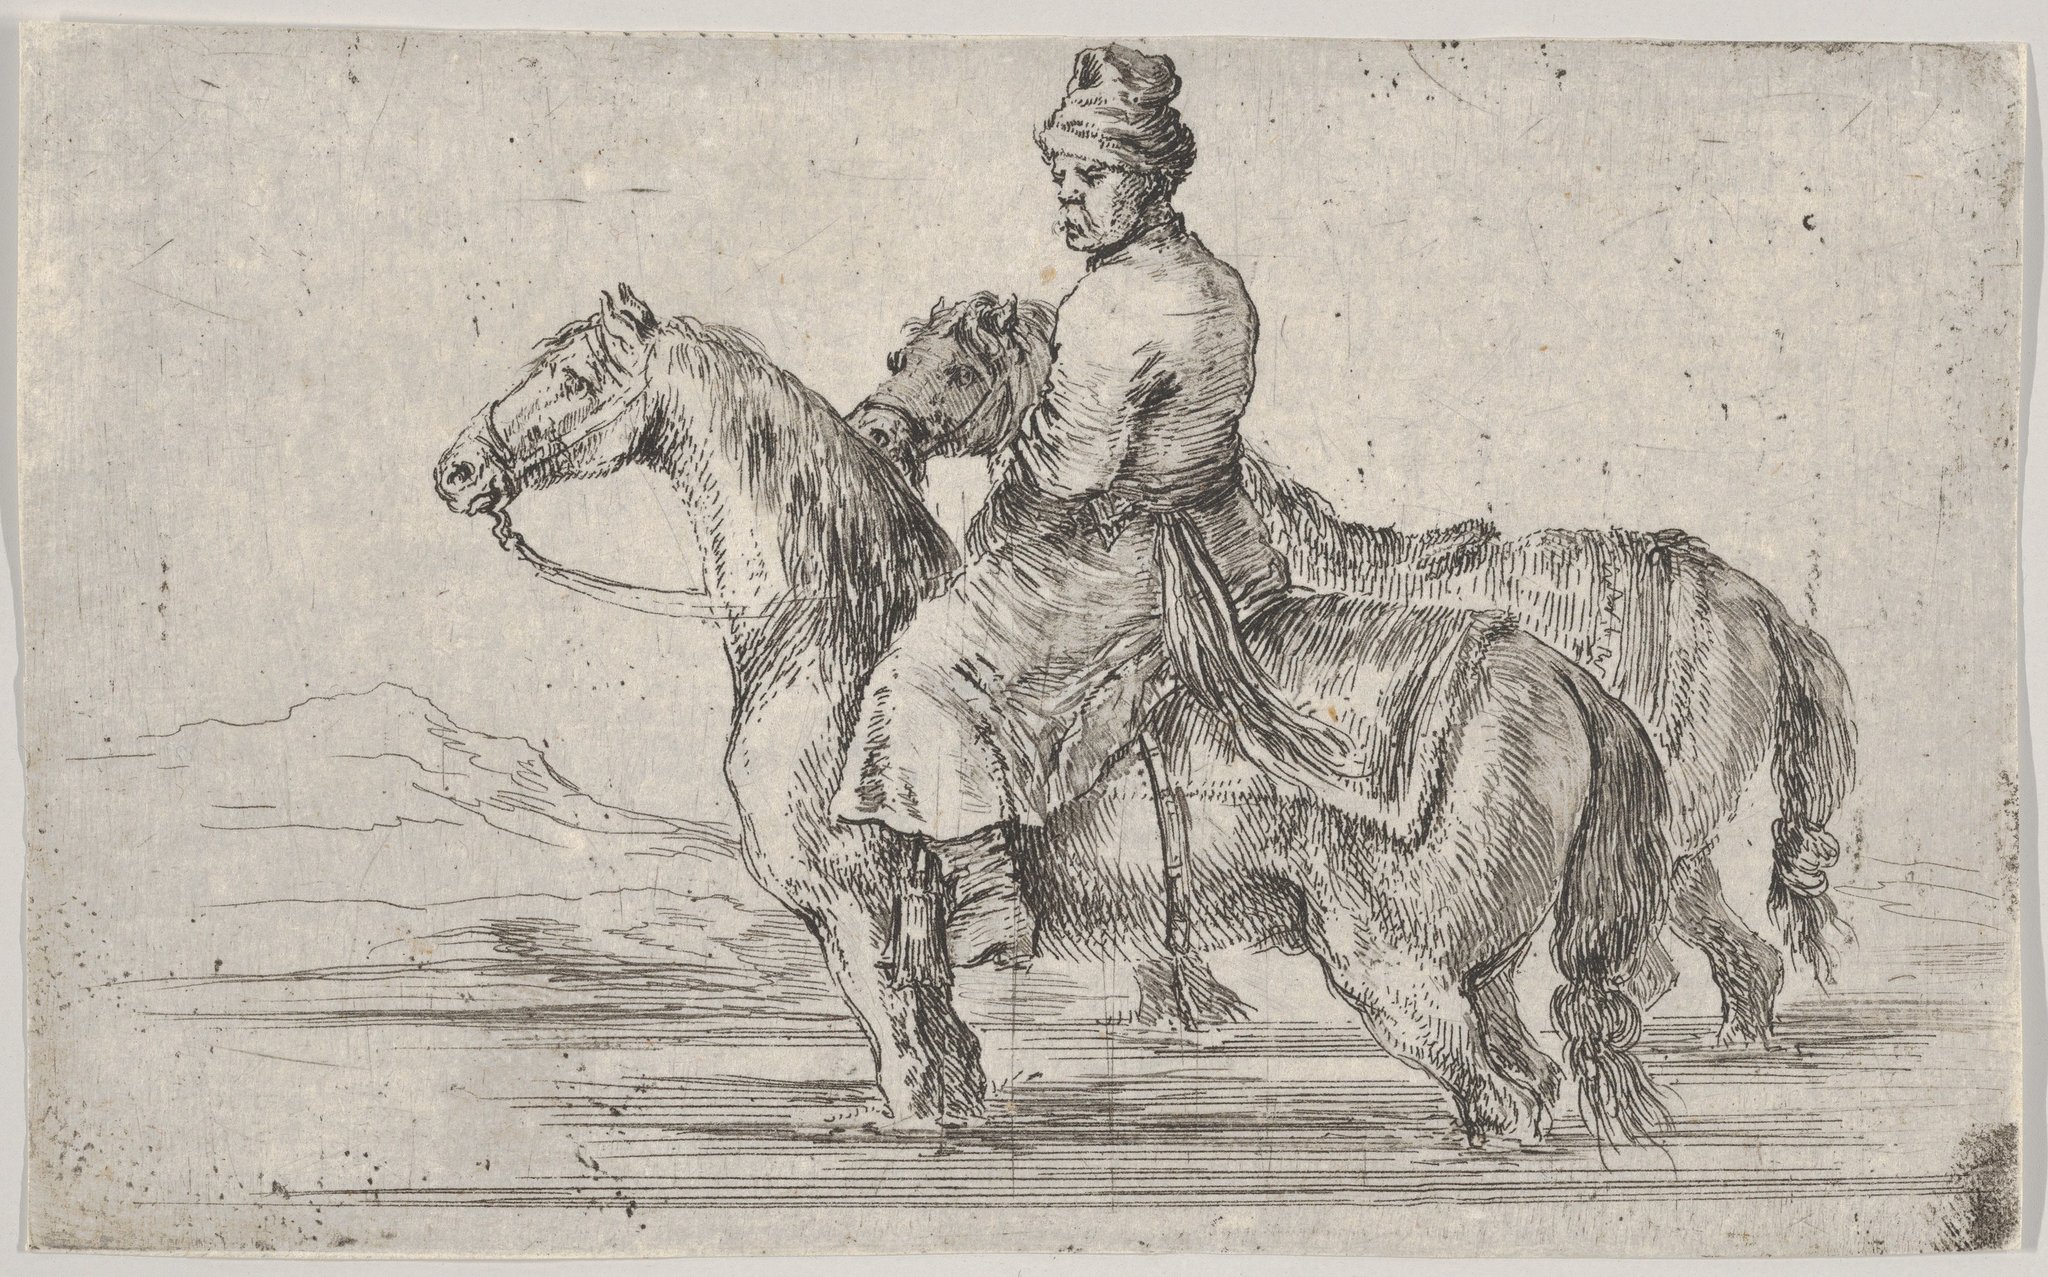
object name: print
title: A valet taking two horses to bathe, sitting atop one horse in a river, the other beside him to right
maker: stefano della bella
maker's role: artist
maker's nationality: italian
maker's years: 1610-1664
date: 1662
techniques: etching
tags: men,horses,rivers